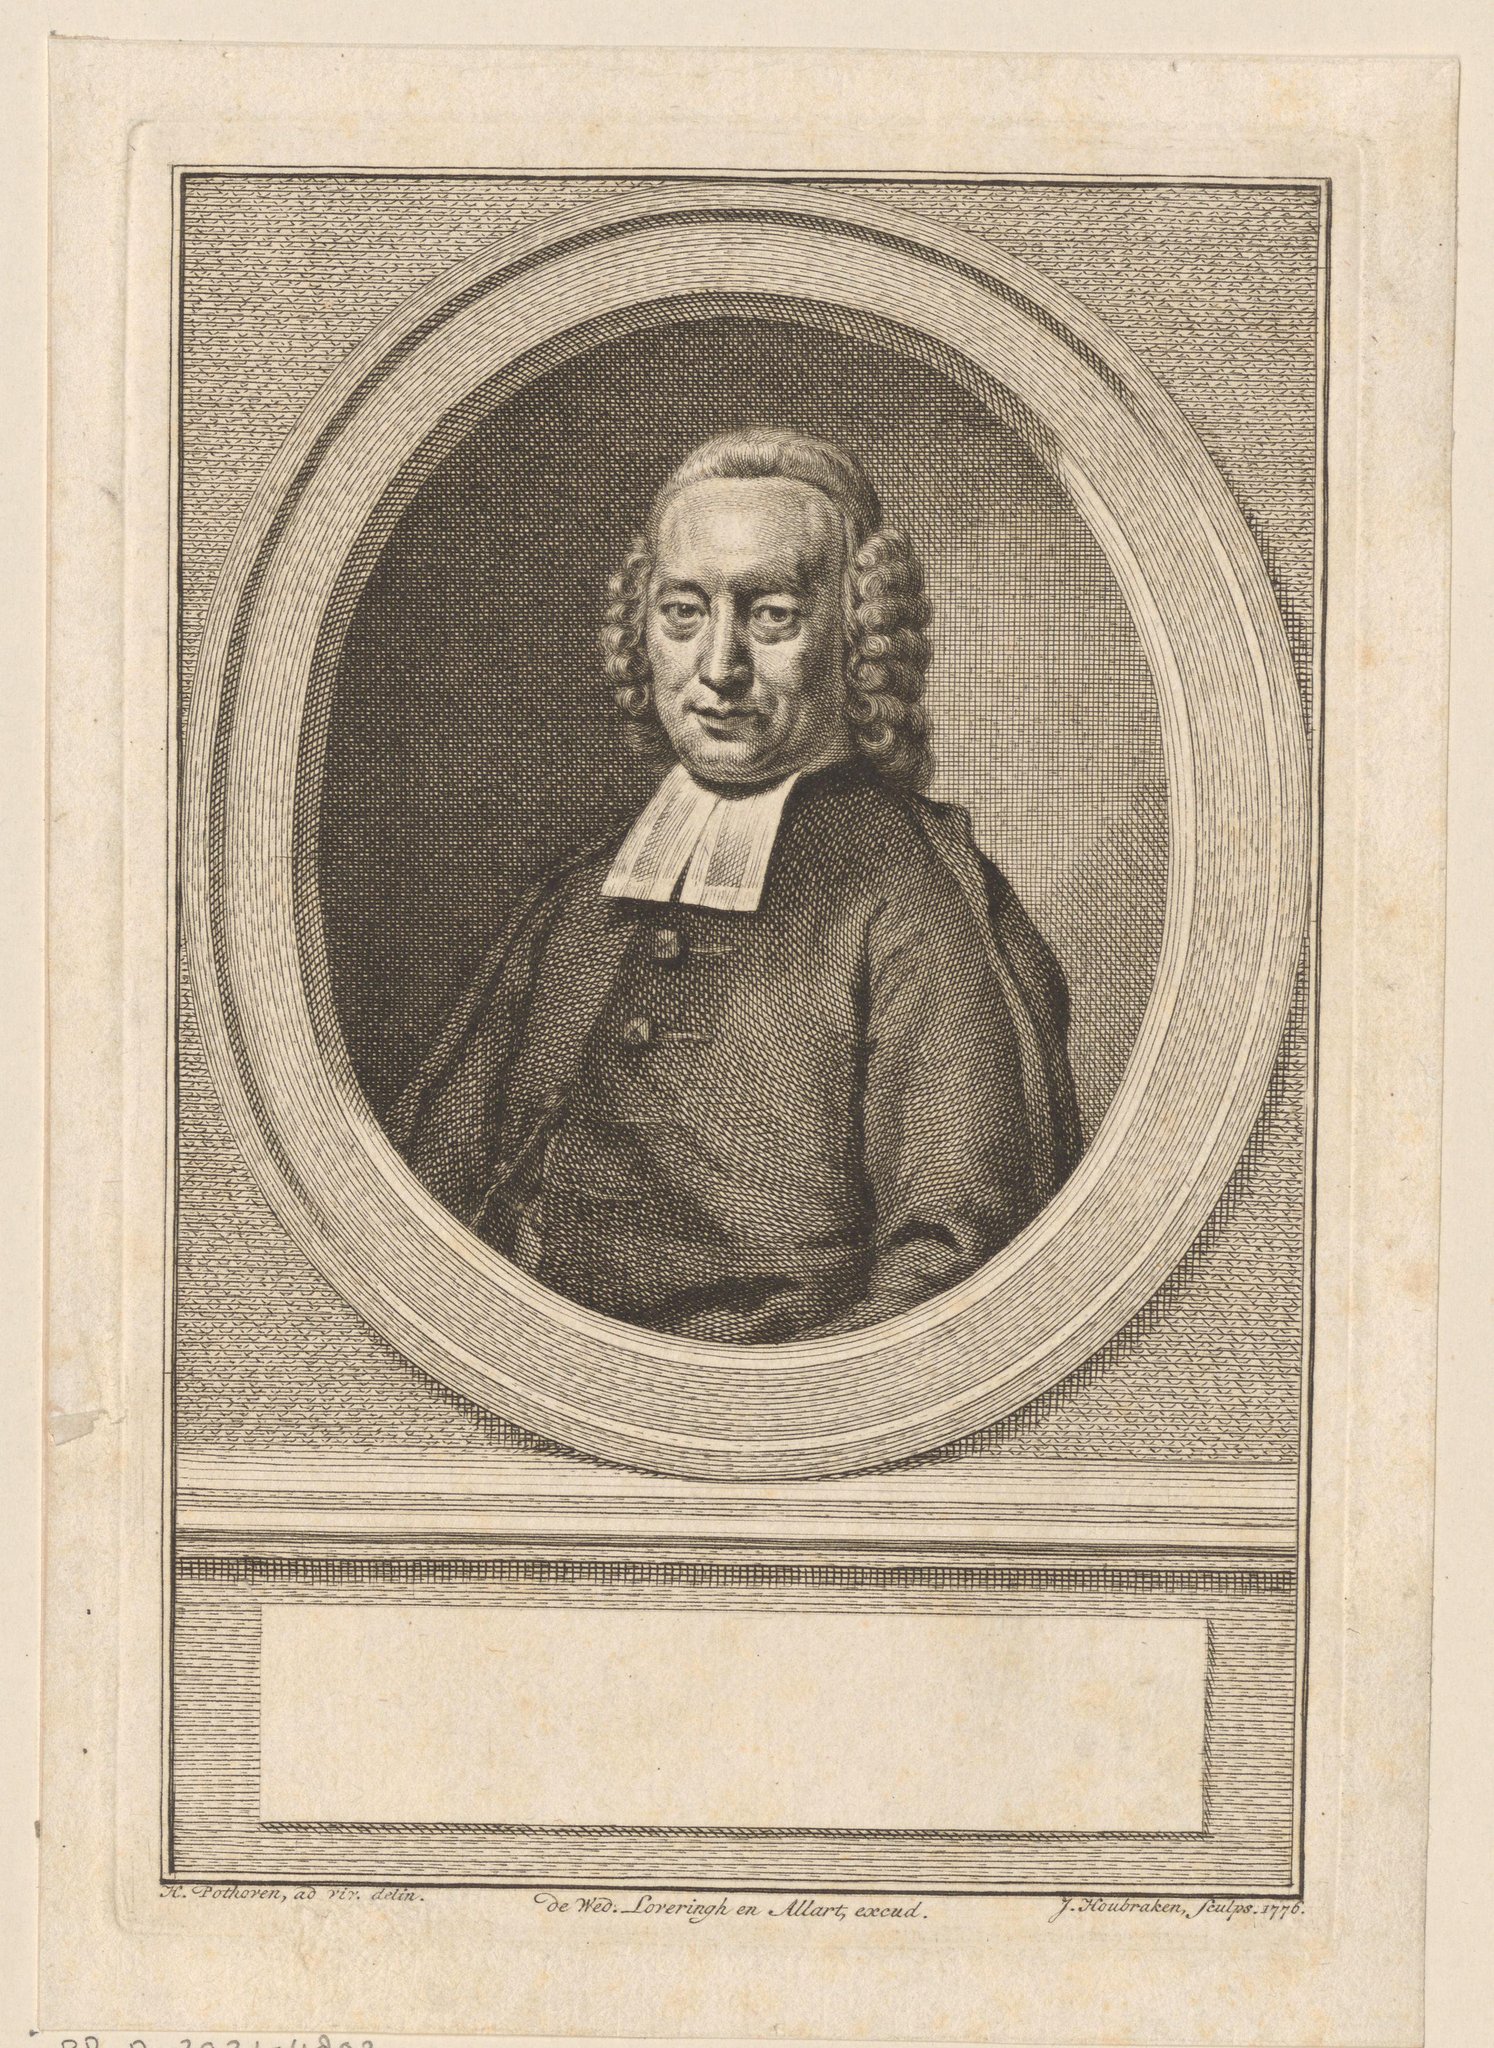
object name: print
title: Portret van Jacobus Hinlopen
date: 1776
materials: paper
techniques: engraving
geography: amsterdam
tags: hoorn (north holland), utrecht, historical persons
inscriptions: collector's mark: Lugt 2228, collector's mark: Lugt 964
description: Prent gebruikt in: Iperen, Josua van. Kerkelyke historie van het psalm-gezang der christenen (...). Amsterdam: weduwe Jacobus Loveringh en Johannes Allart, 1777-1778, dl. 2.